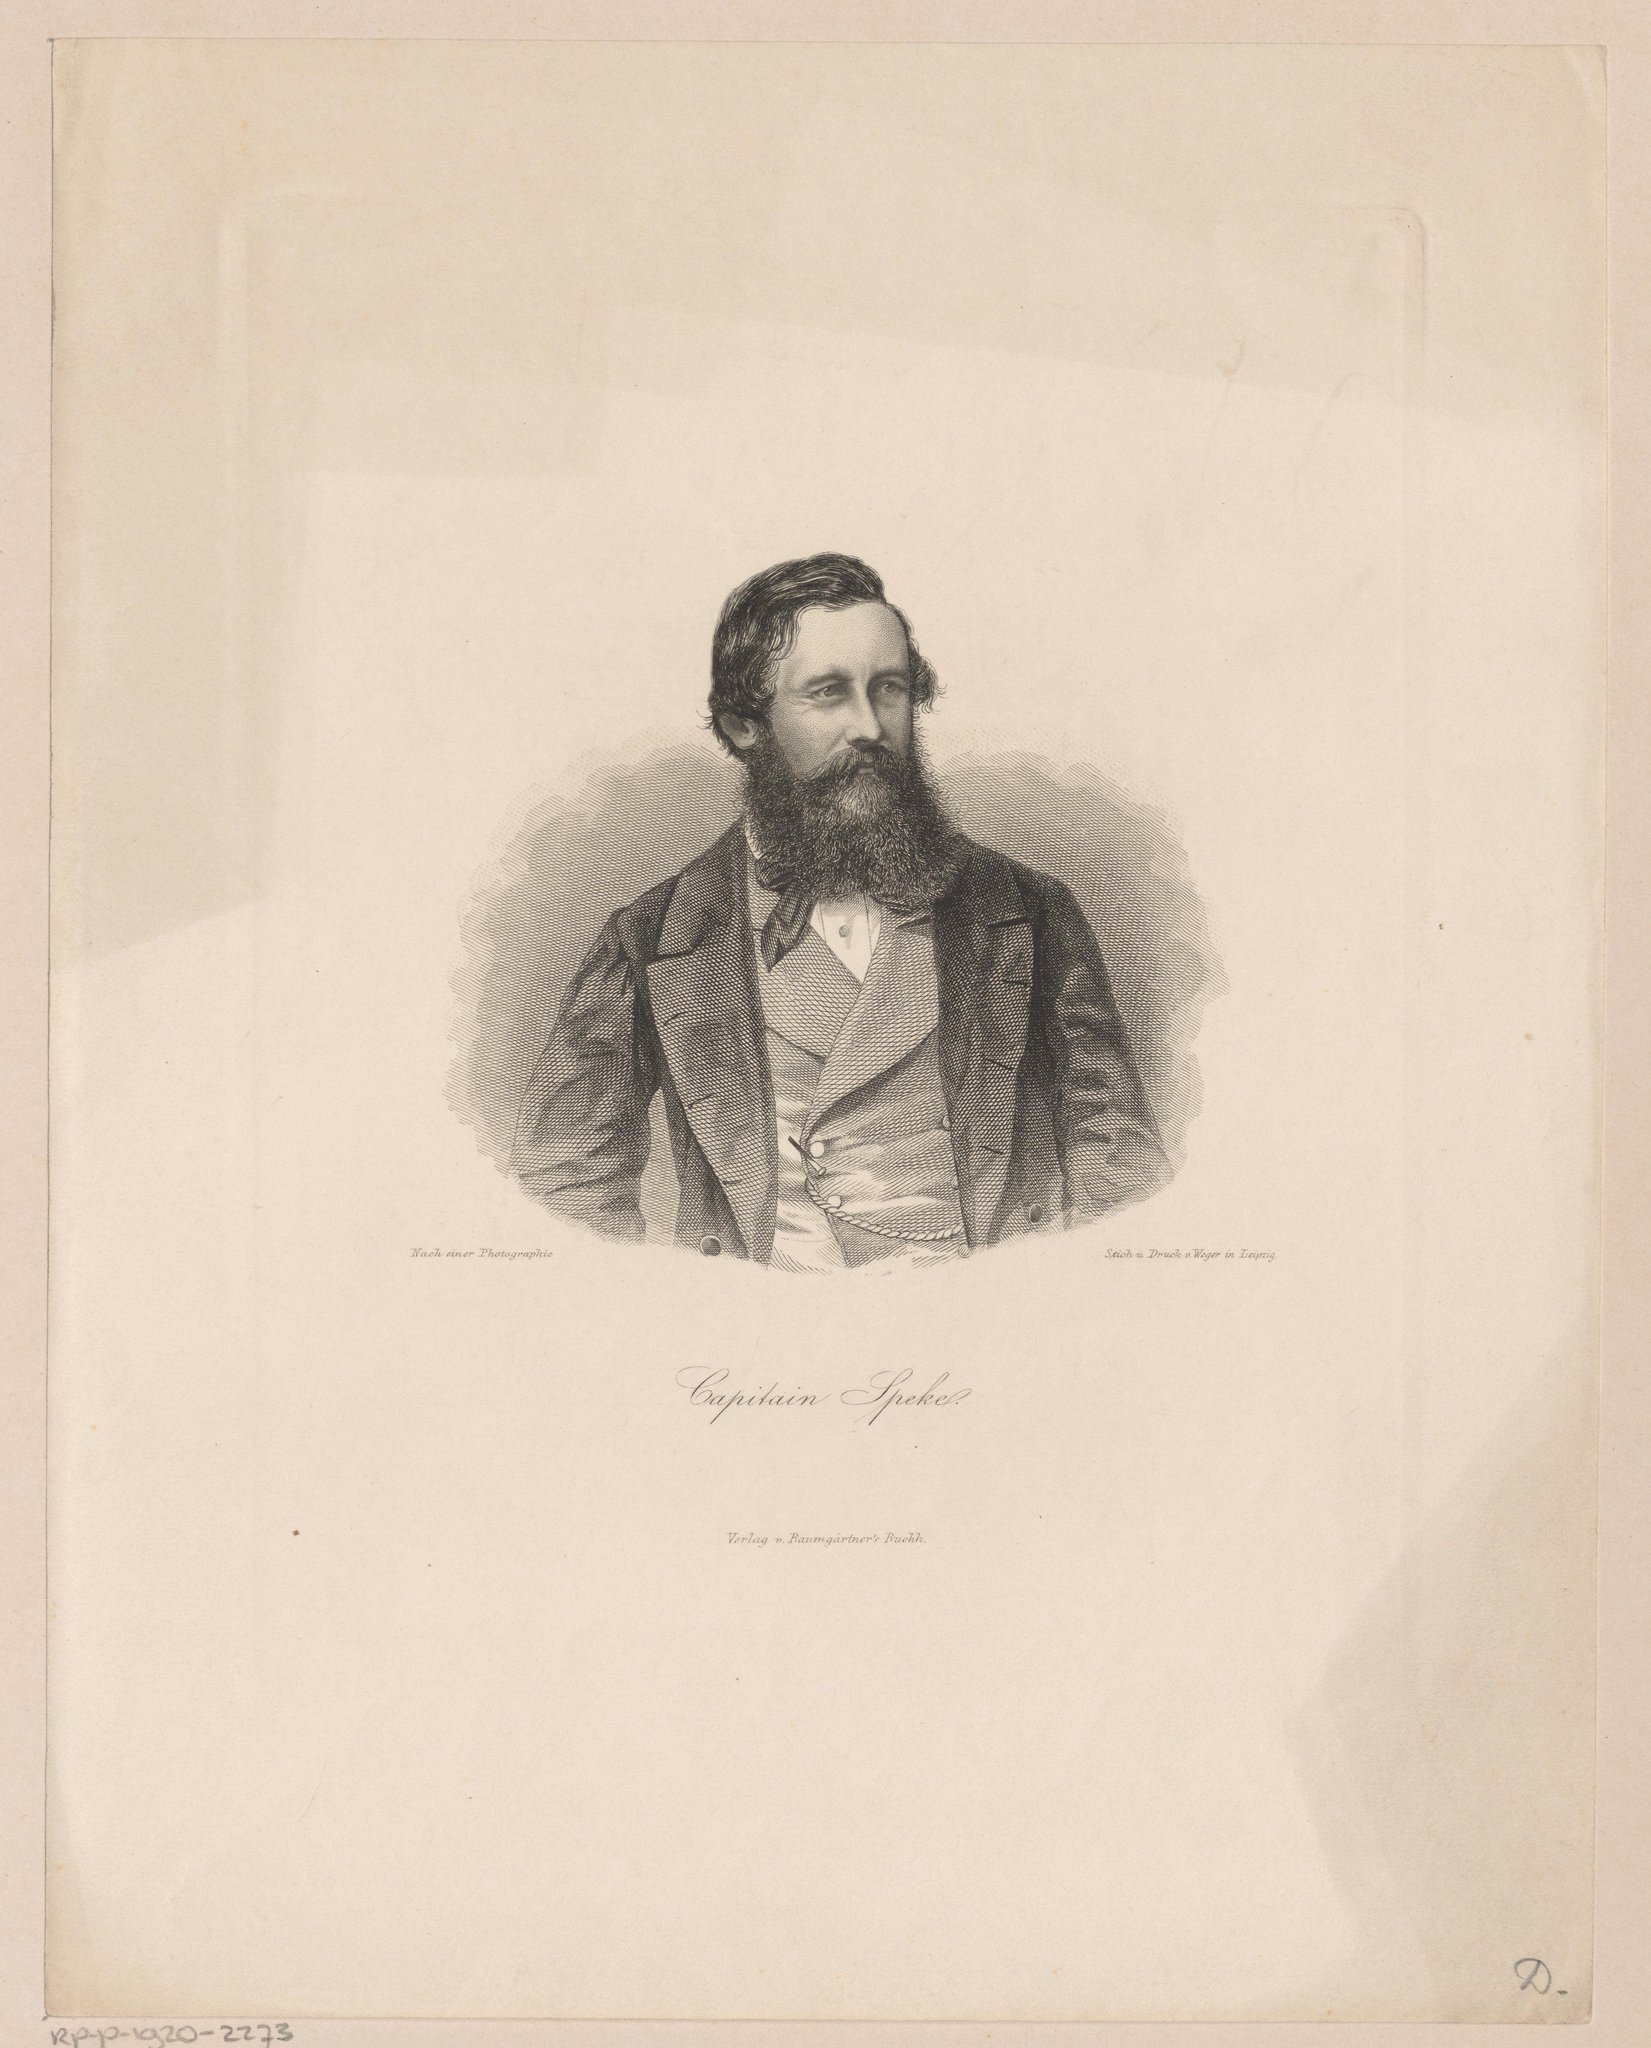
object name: print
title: Portret van John Hanning Speke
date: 1854-1892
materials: paper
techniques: engraving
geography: leipzig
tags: historical persons, explorer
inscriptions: collector's mark: Lugt 2228